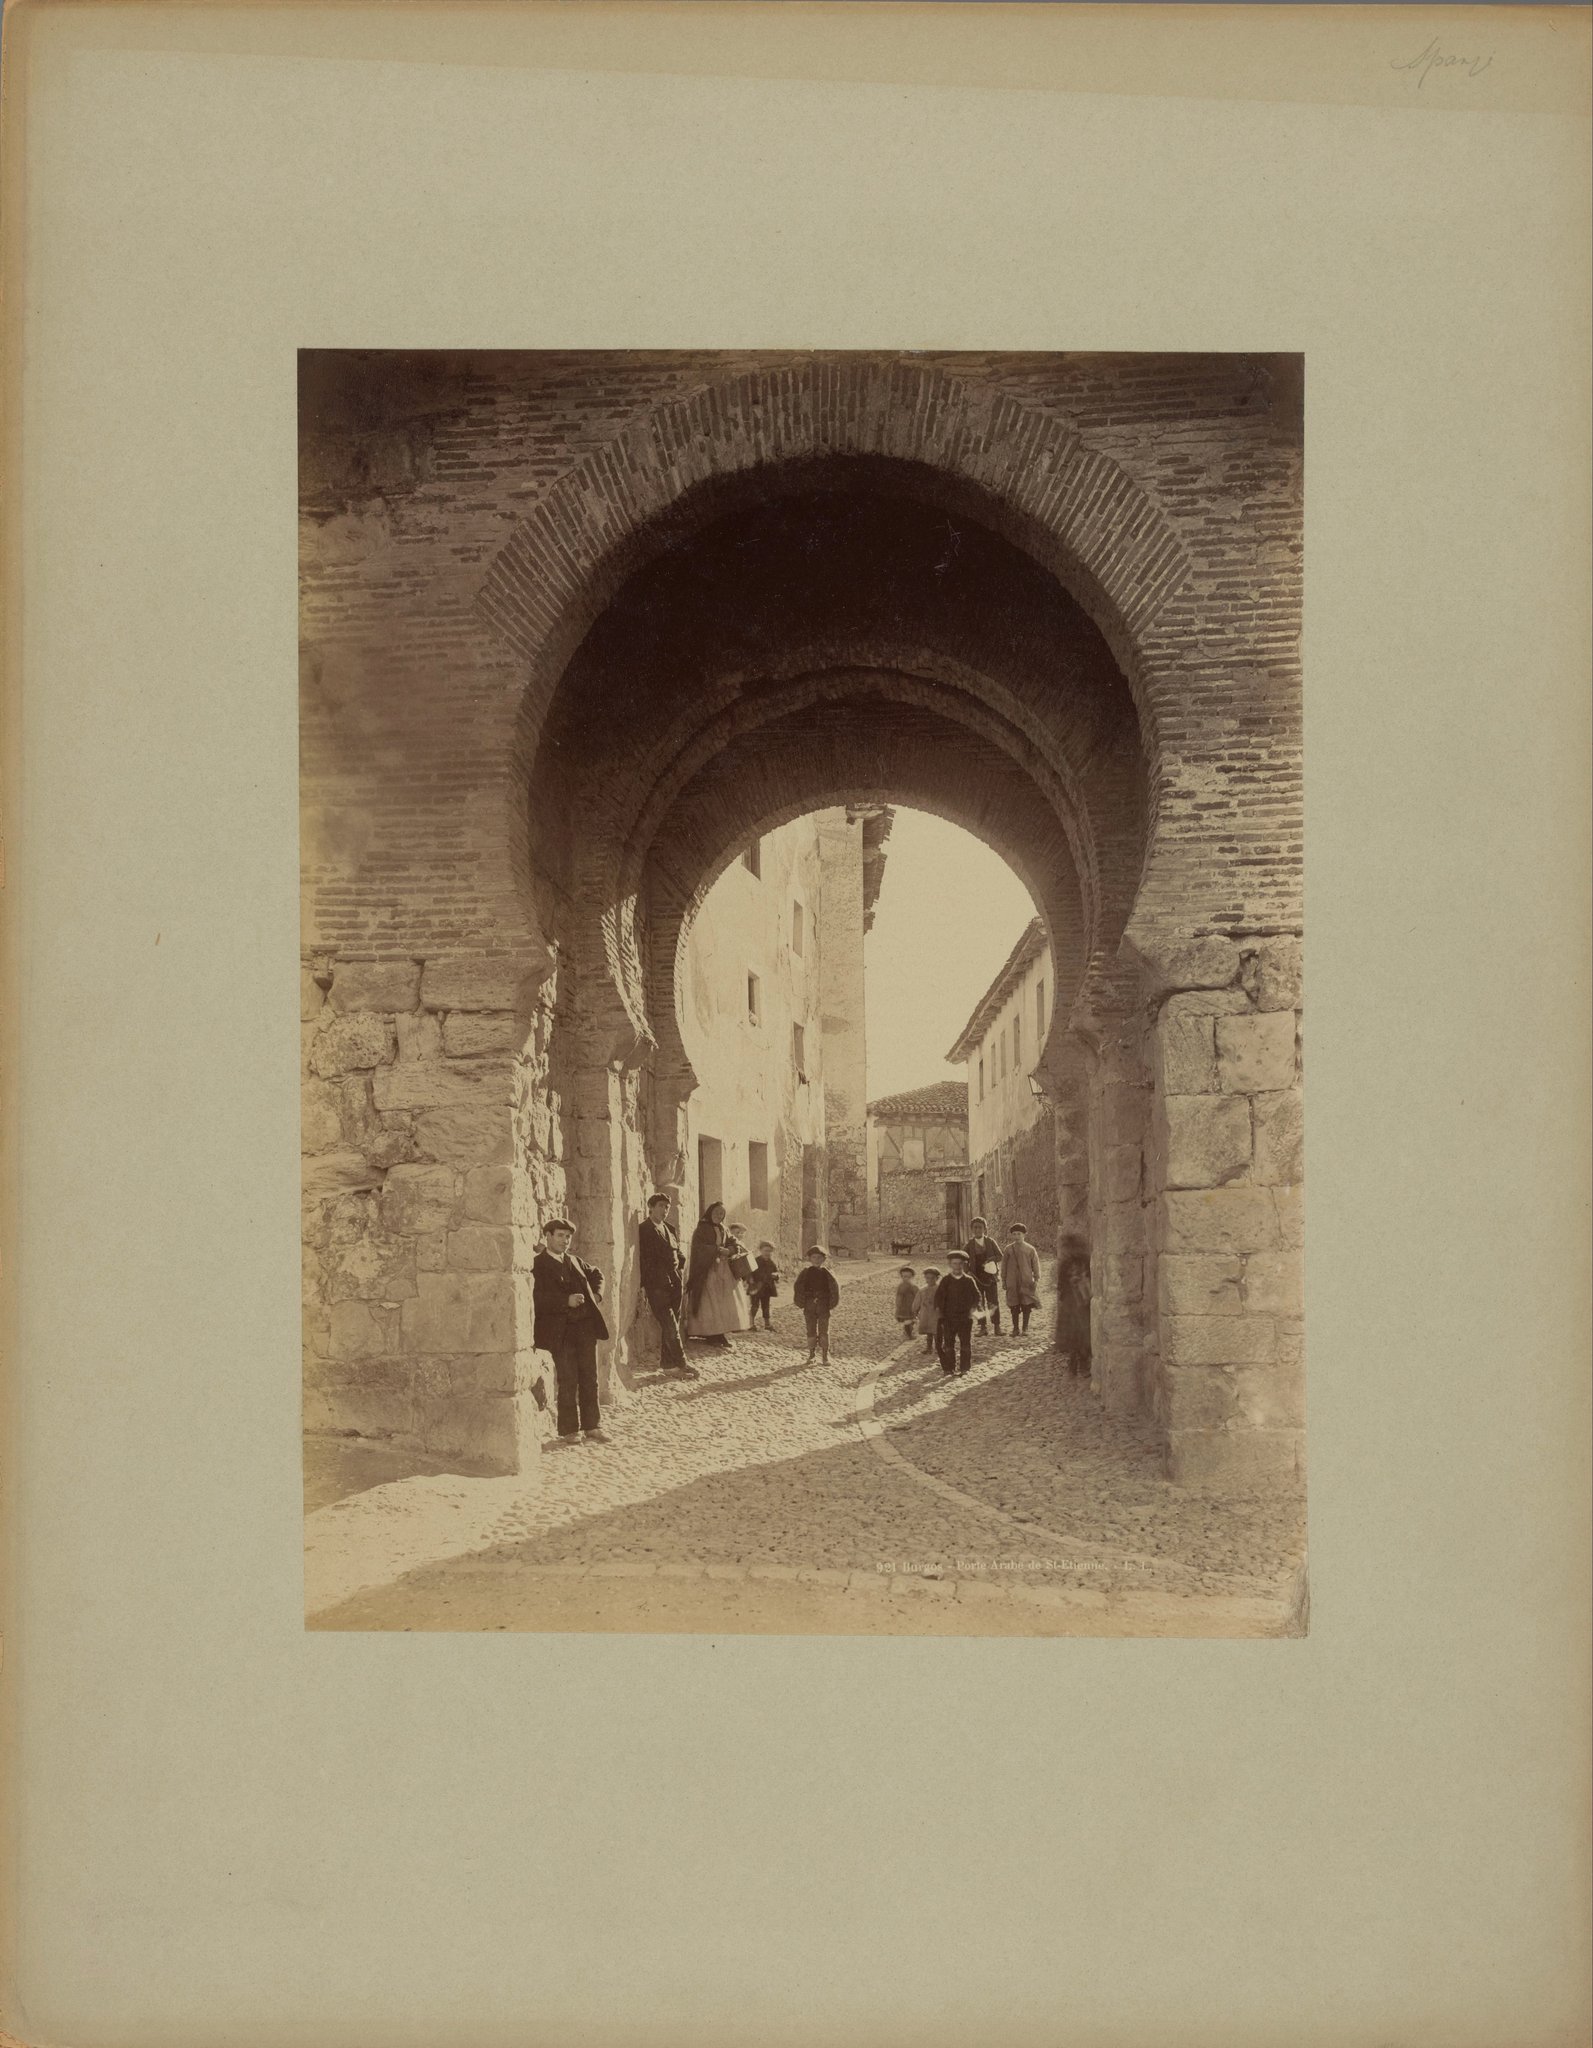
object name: photograph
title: Interieur van de kathedraal van Avila, gezien naar het koor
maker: Anonymous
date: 1875-1900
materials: cardboard, photographic support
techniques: albumen print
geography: avila cathedral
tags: parts of church interior: choir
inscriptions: collector's mark: Lugt 3937, number: ‘2216’